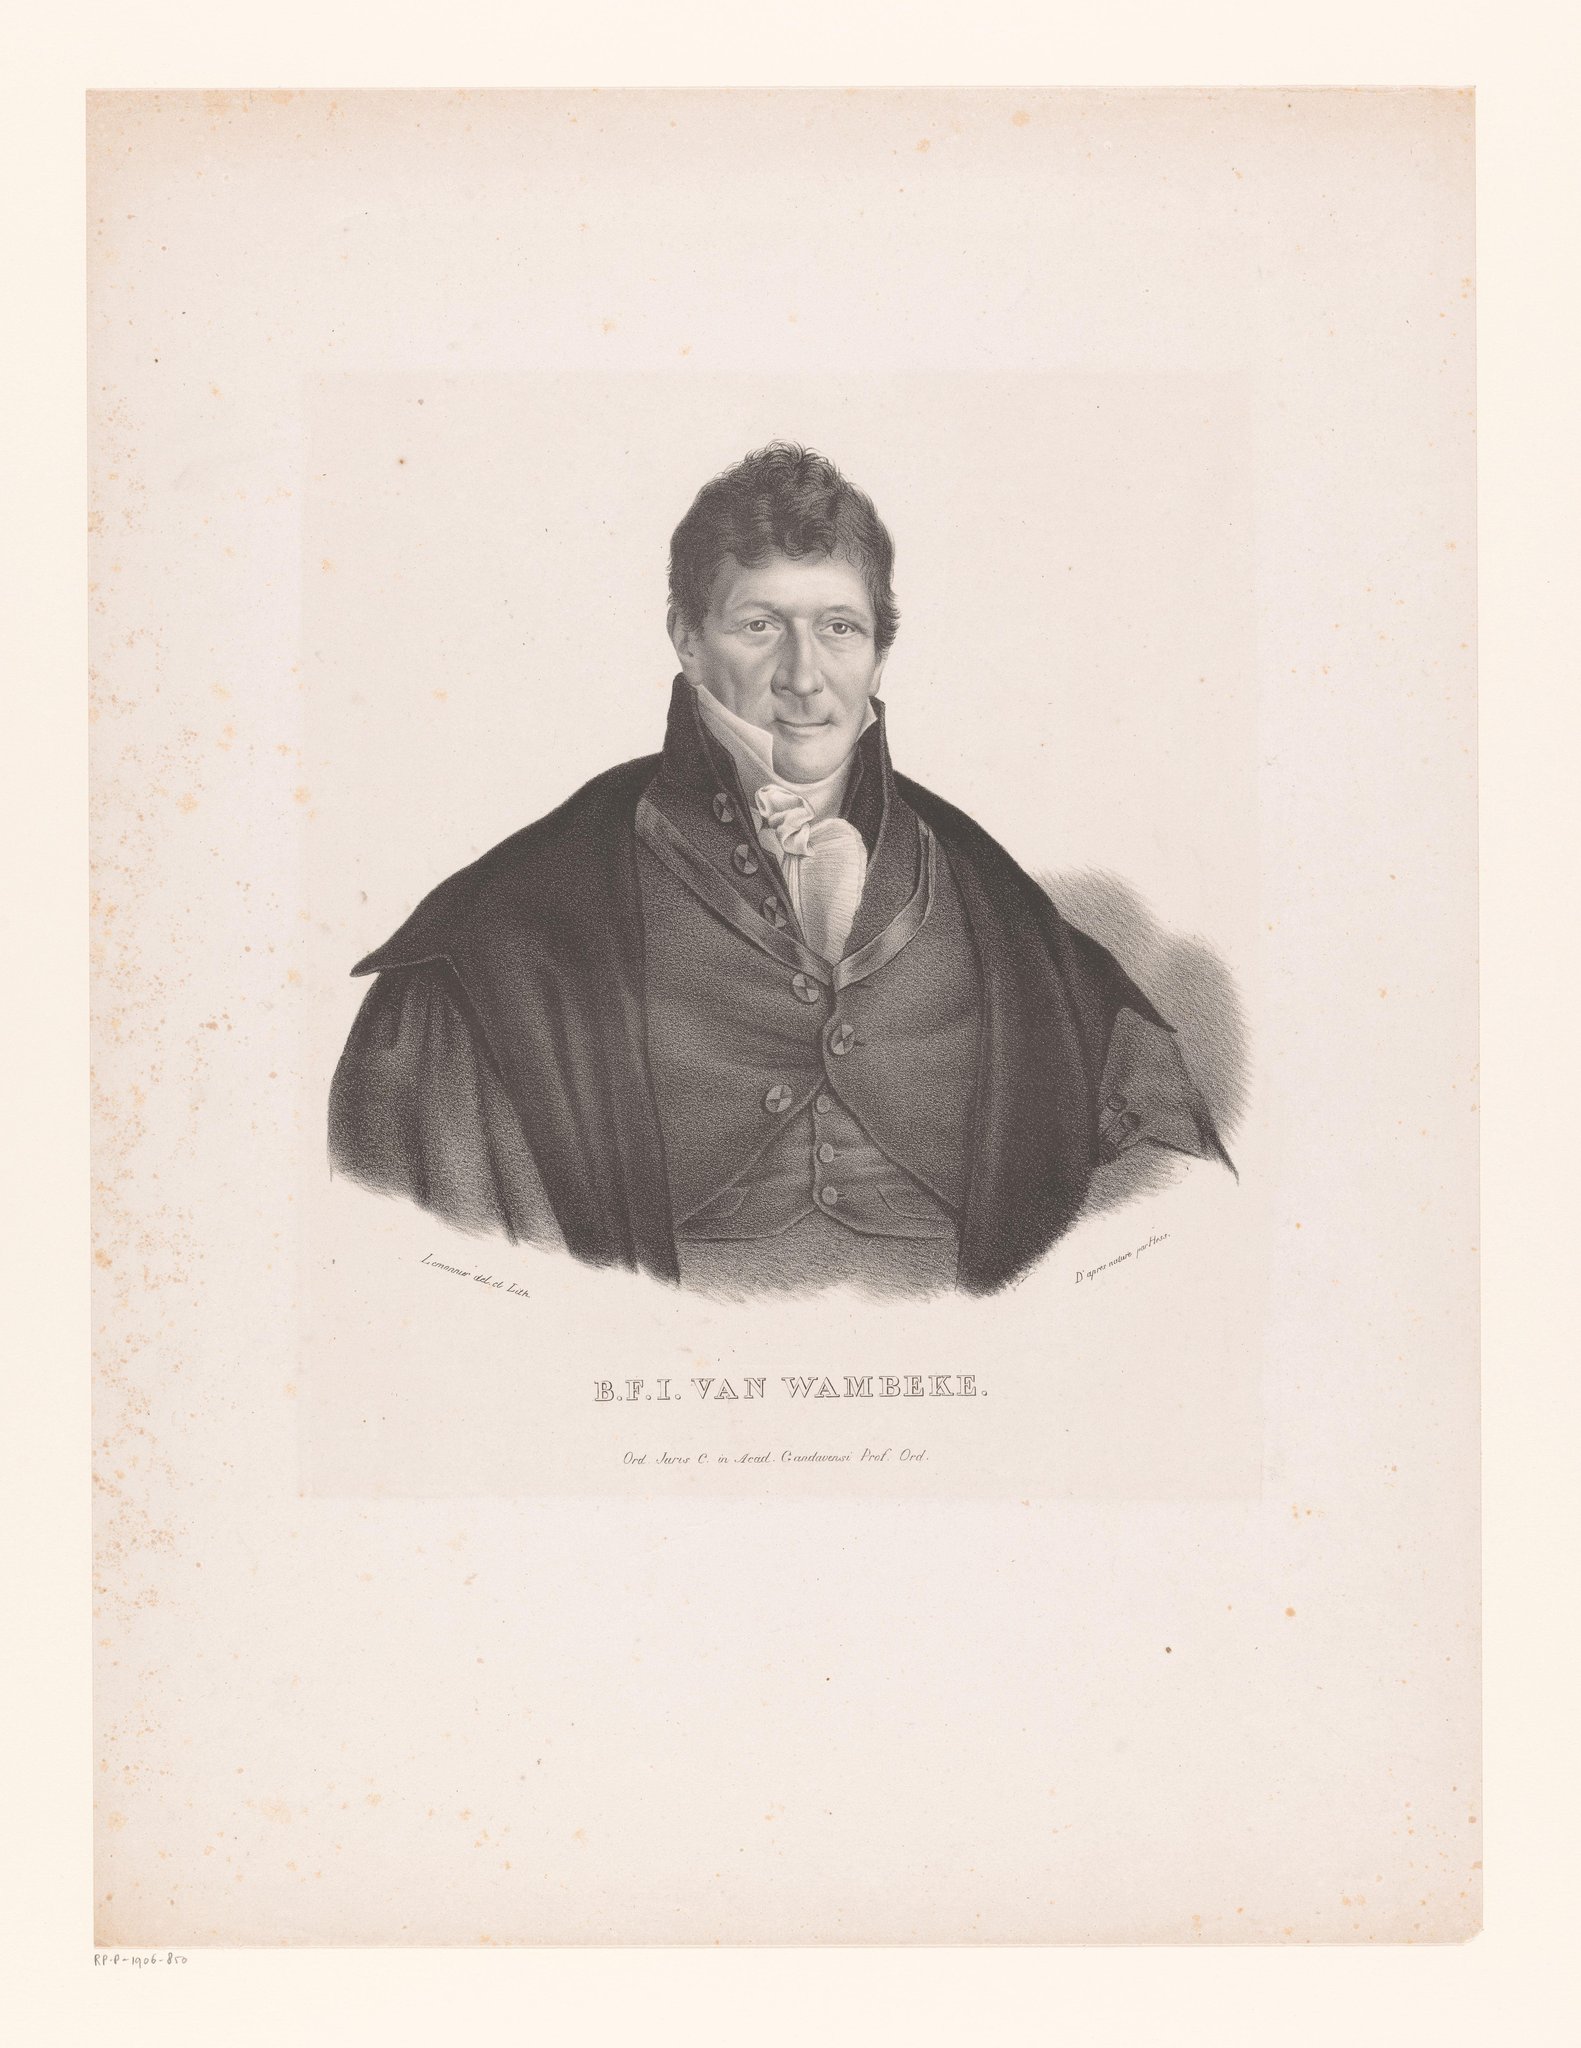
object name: print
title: Portret van Bernard François Joseph Van Wambeke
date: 1827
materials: paper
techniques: lithograph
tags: historical persons, professor (+ portrait of teacher, professor)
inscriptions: collector's mark: Lugt 2228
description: Prent verschenen in: Hess, Marcel. Iconographie des professeurs des universites des Pays-Bas. Brussel: Van Someren, 1827.